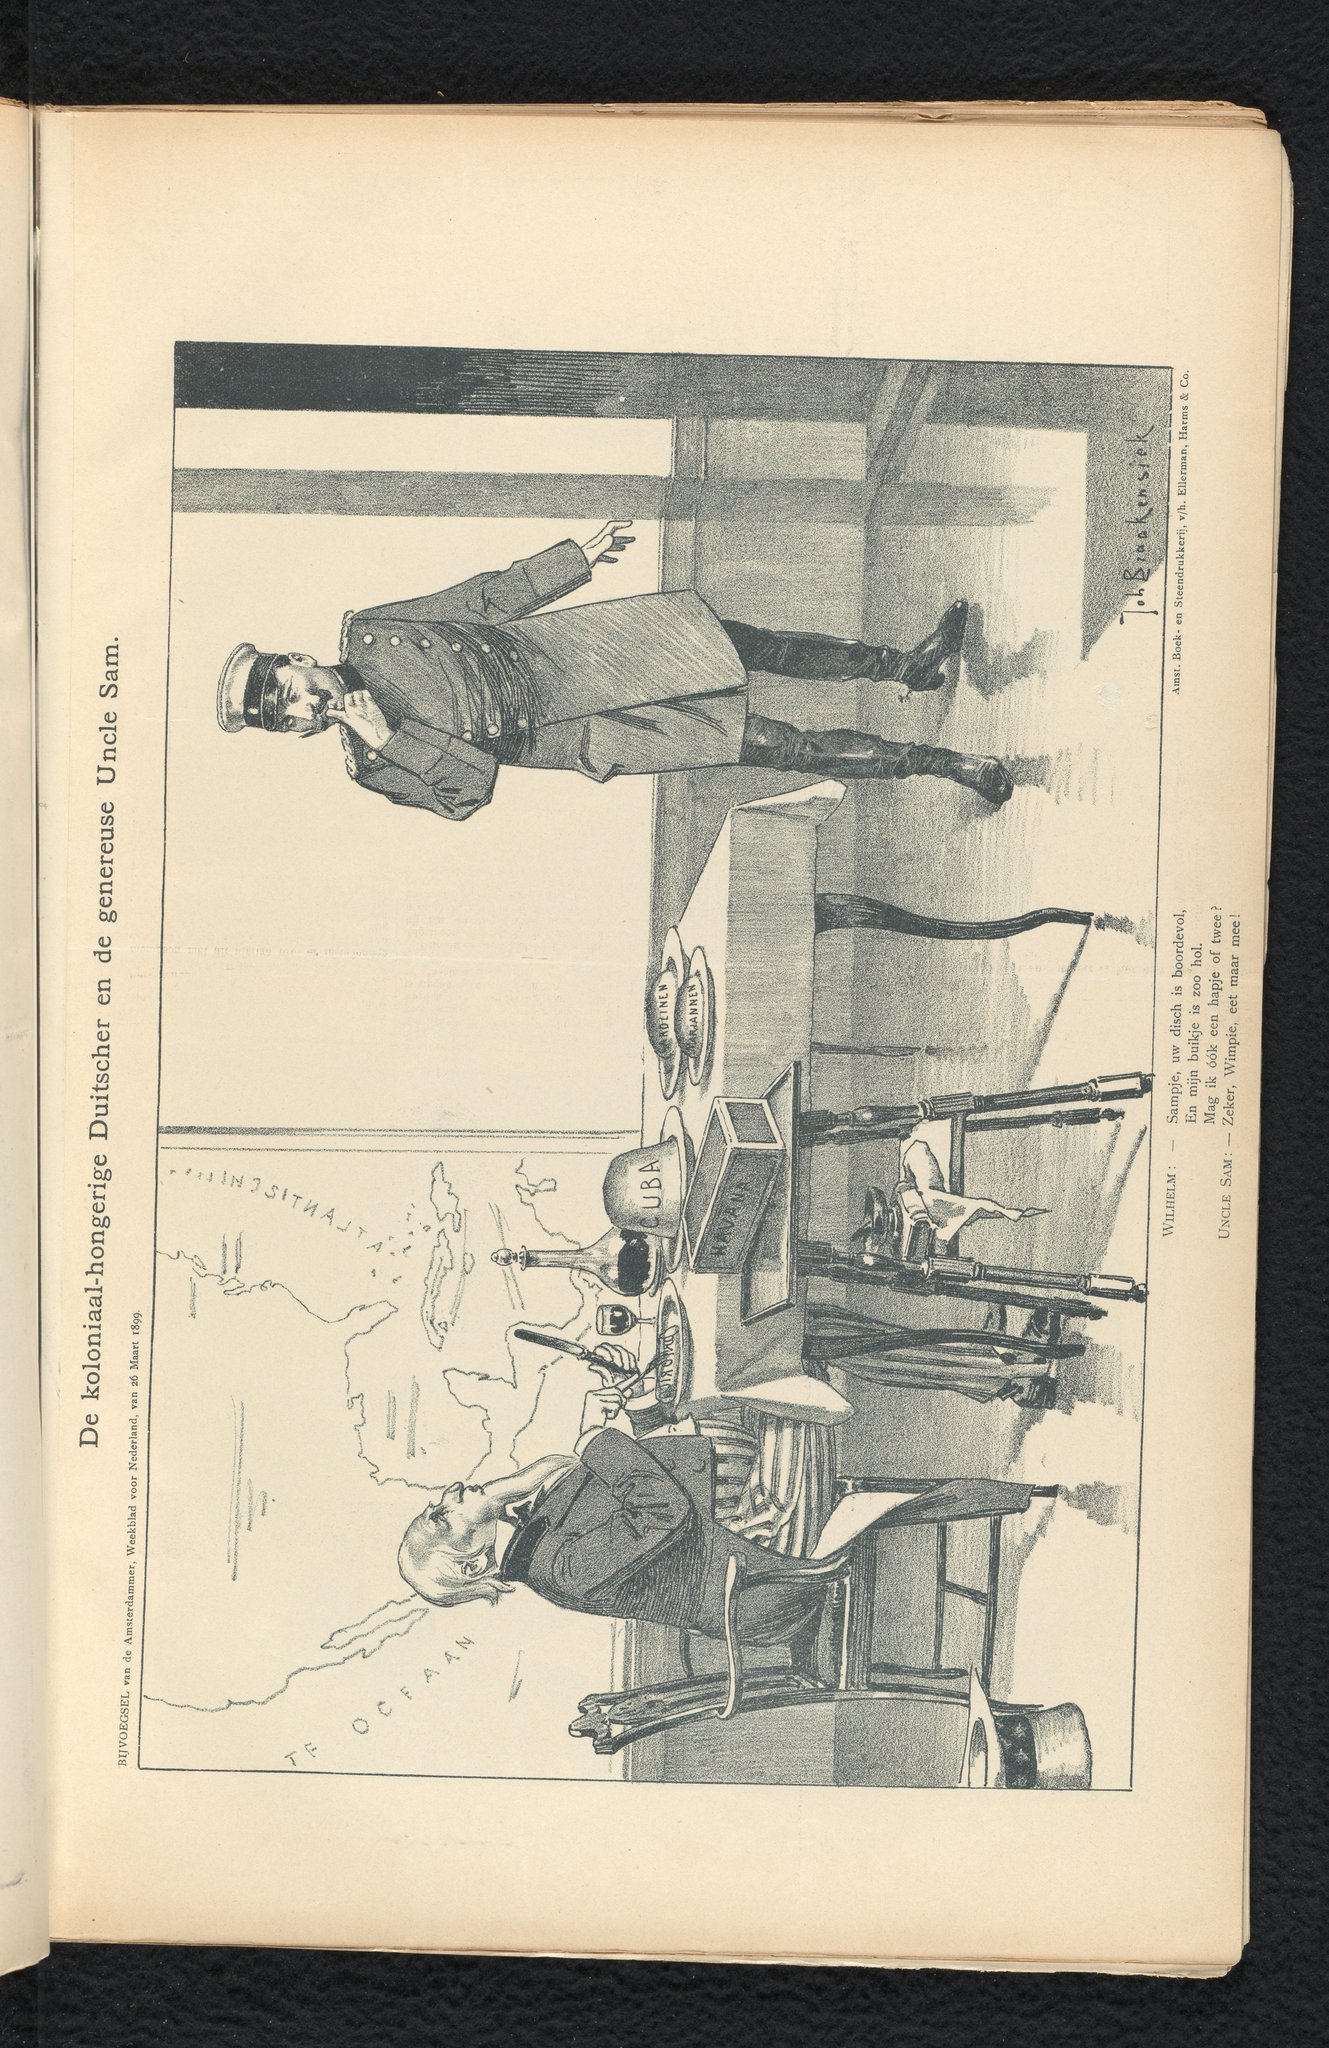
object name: cartoon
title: De koloniaal-hongerige Duitscher en de genereuse Uncle Sam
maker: johan braakensiek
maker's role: draughtsman, print maker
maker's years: 1858-1940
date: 1899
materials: paper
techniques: lithograph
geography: netherlands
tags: wilhelm ii (keizer van duitsland), hunger, imperialism, personifications of countries, nations, states, districts, etc., (family) meal, political caricatures and satires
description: De Duitse keizer Wilhelm II mag mee-eten aan de volle tafel van Uncle Sam (Verenigde Staten). Duitsland is hongerig naar de koloniën die als gerechten op de tafel staan, onder andere de Marianen en Carolinen.